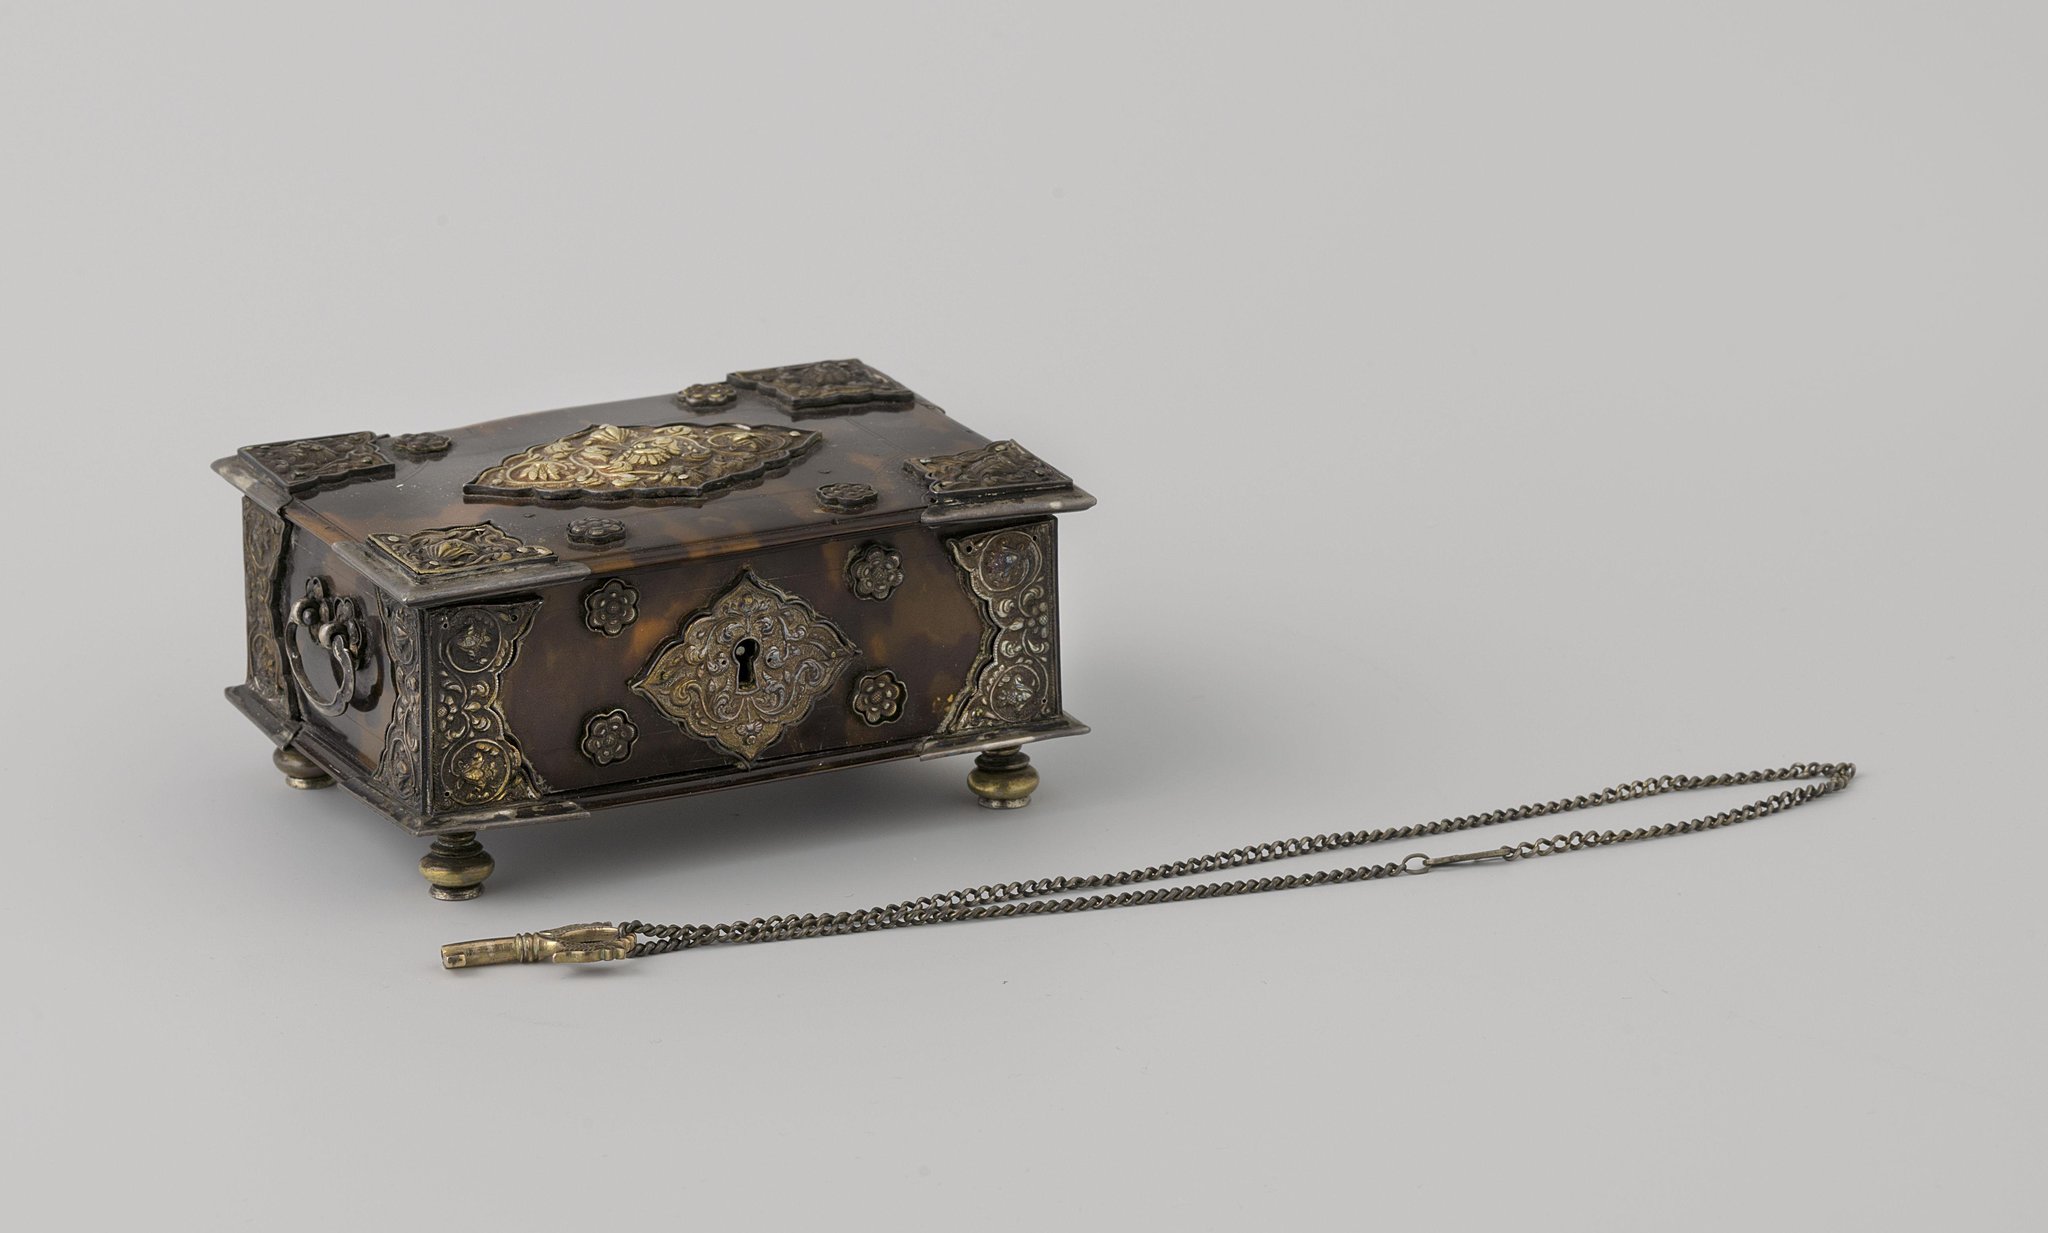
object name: sirihkist, sirihdoos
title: Sirihdoos van schildpad met beslag van goud en zilver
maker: Anonymous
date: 1600-1699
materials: gold, silver, shell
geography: indonesia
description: Sirih box tortoiseshell, gold and silver mounts Indonesia, 18th century